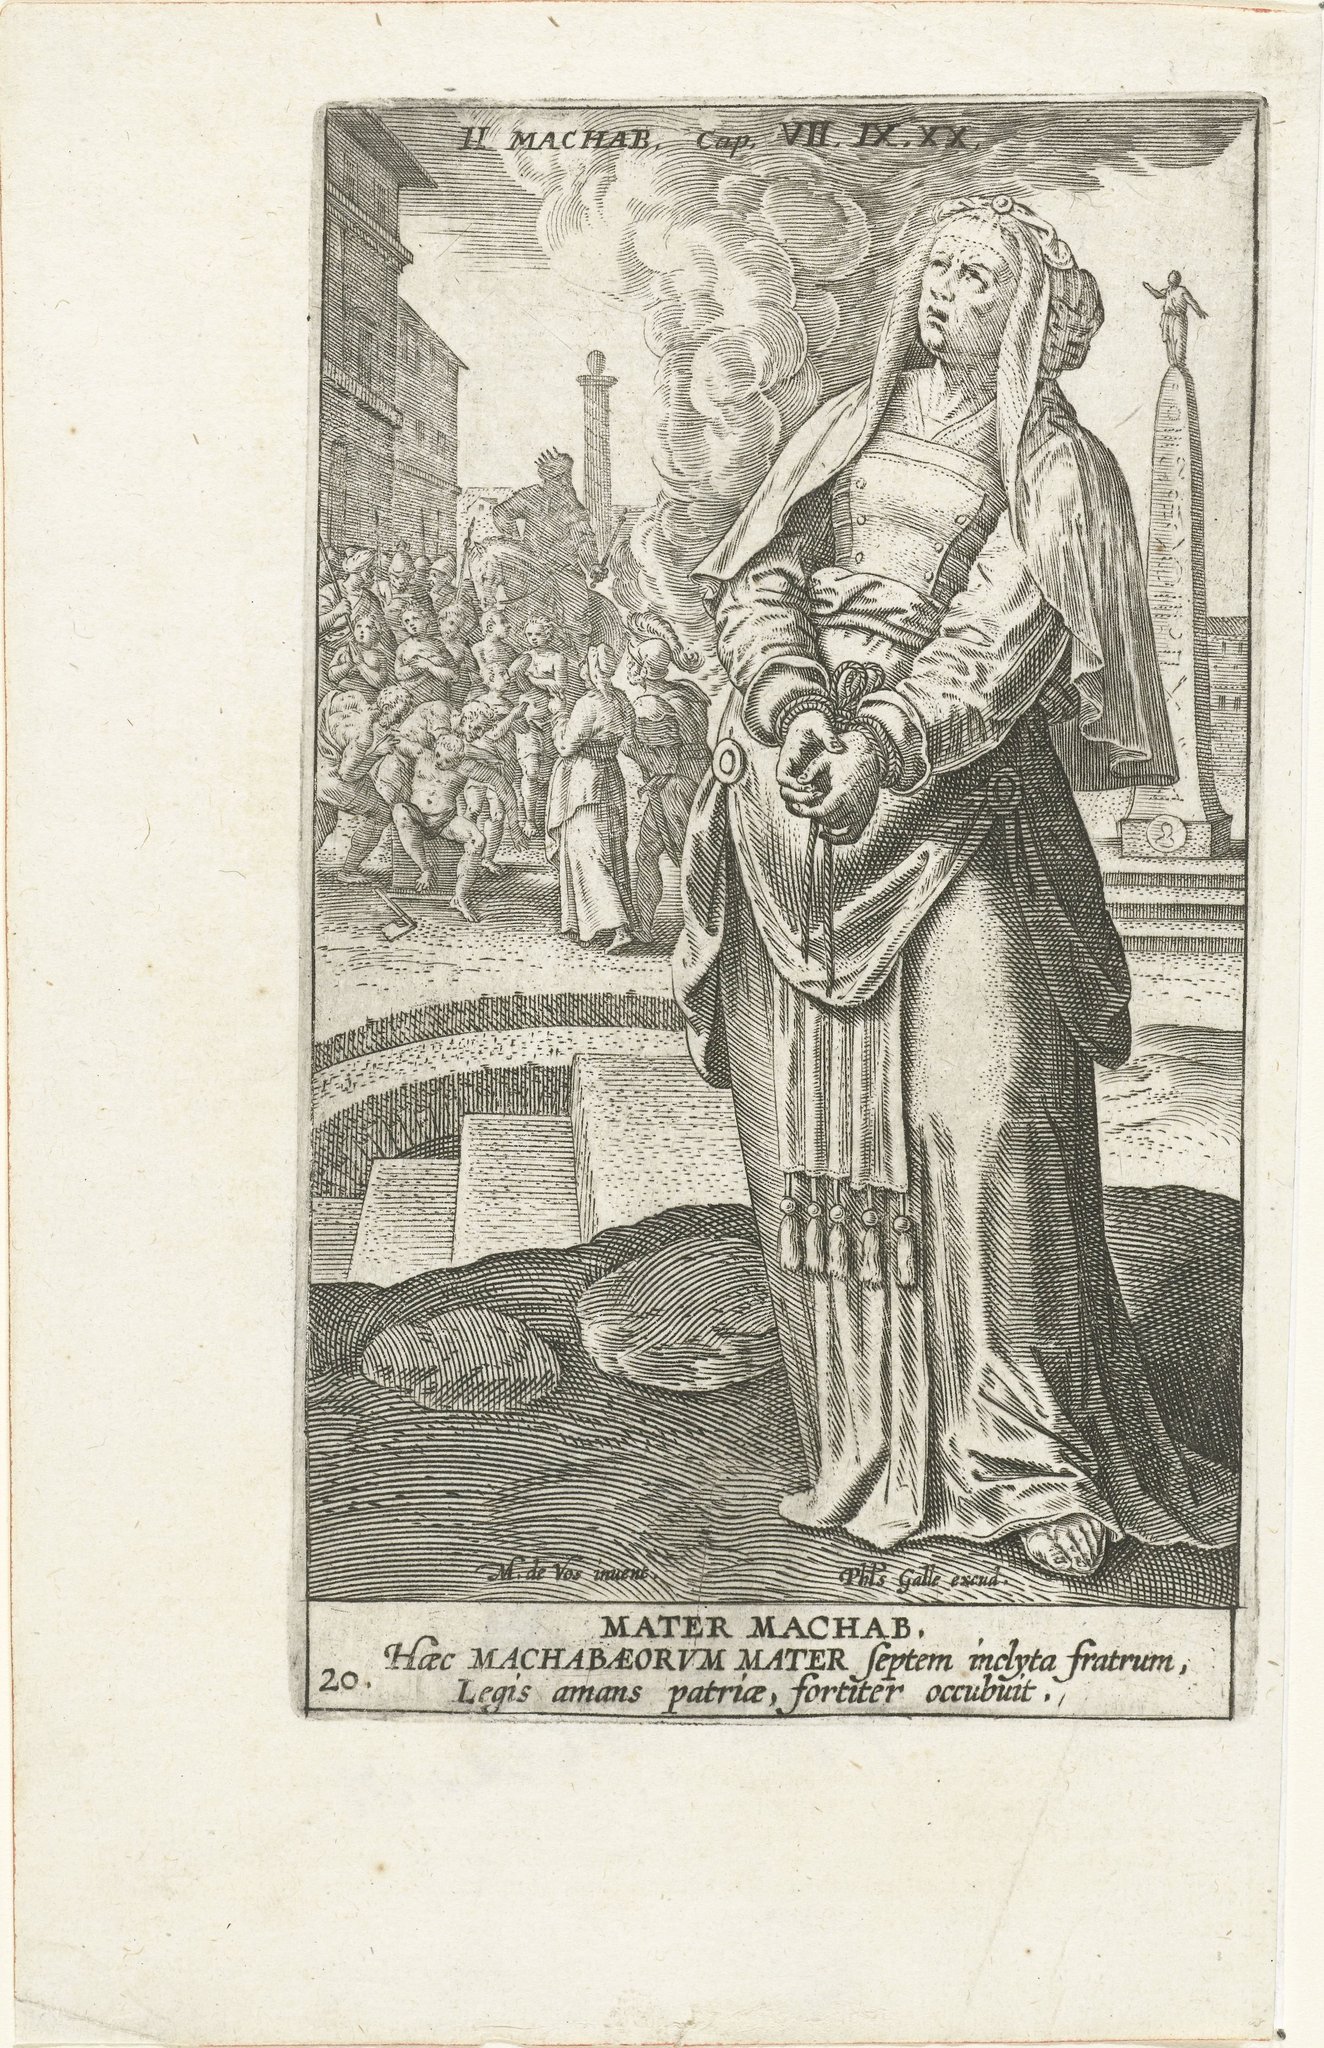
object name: print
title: Icones Illvstrivm Feminarvm Veteris Testamenti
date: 1588-1597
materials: paper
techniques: engraving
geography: antwerp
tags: the martyrdom of the seven maccabean brothers and their mother under antiochus iv epiphanes (2 maccabees 7)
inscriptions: collector's mark: Lugt 2228, collector's mark: Lugt 2760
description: Op de voorgrond de moeder van de Makkabeeën, die geketend haar ogen opslaat naar de hemel. Op de achtergrond worden haar zeven zoons door een koning gemarteld. De prent heeft een Latijns onderschrift en maakt deel uit van een prentserie met beroemde vrouwen uit het Oude Testament.